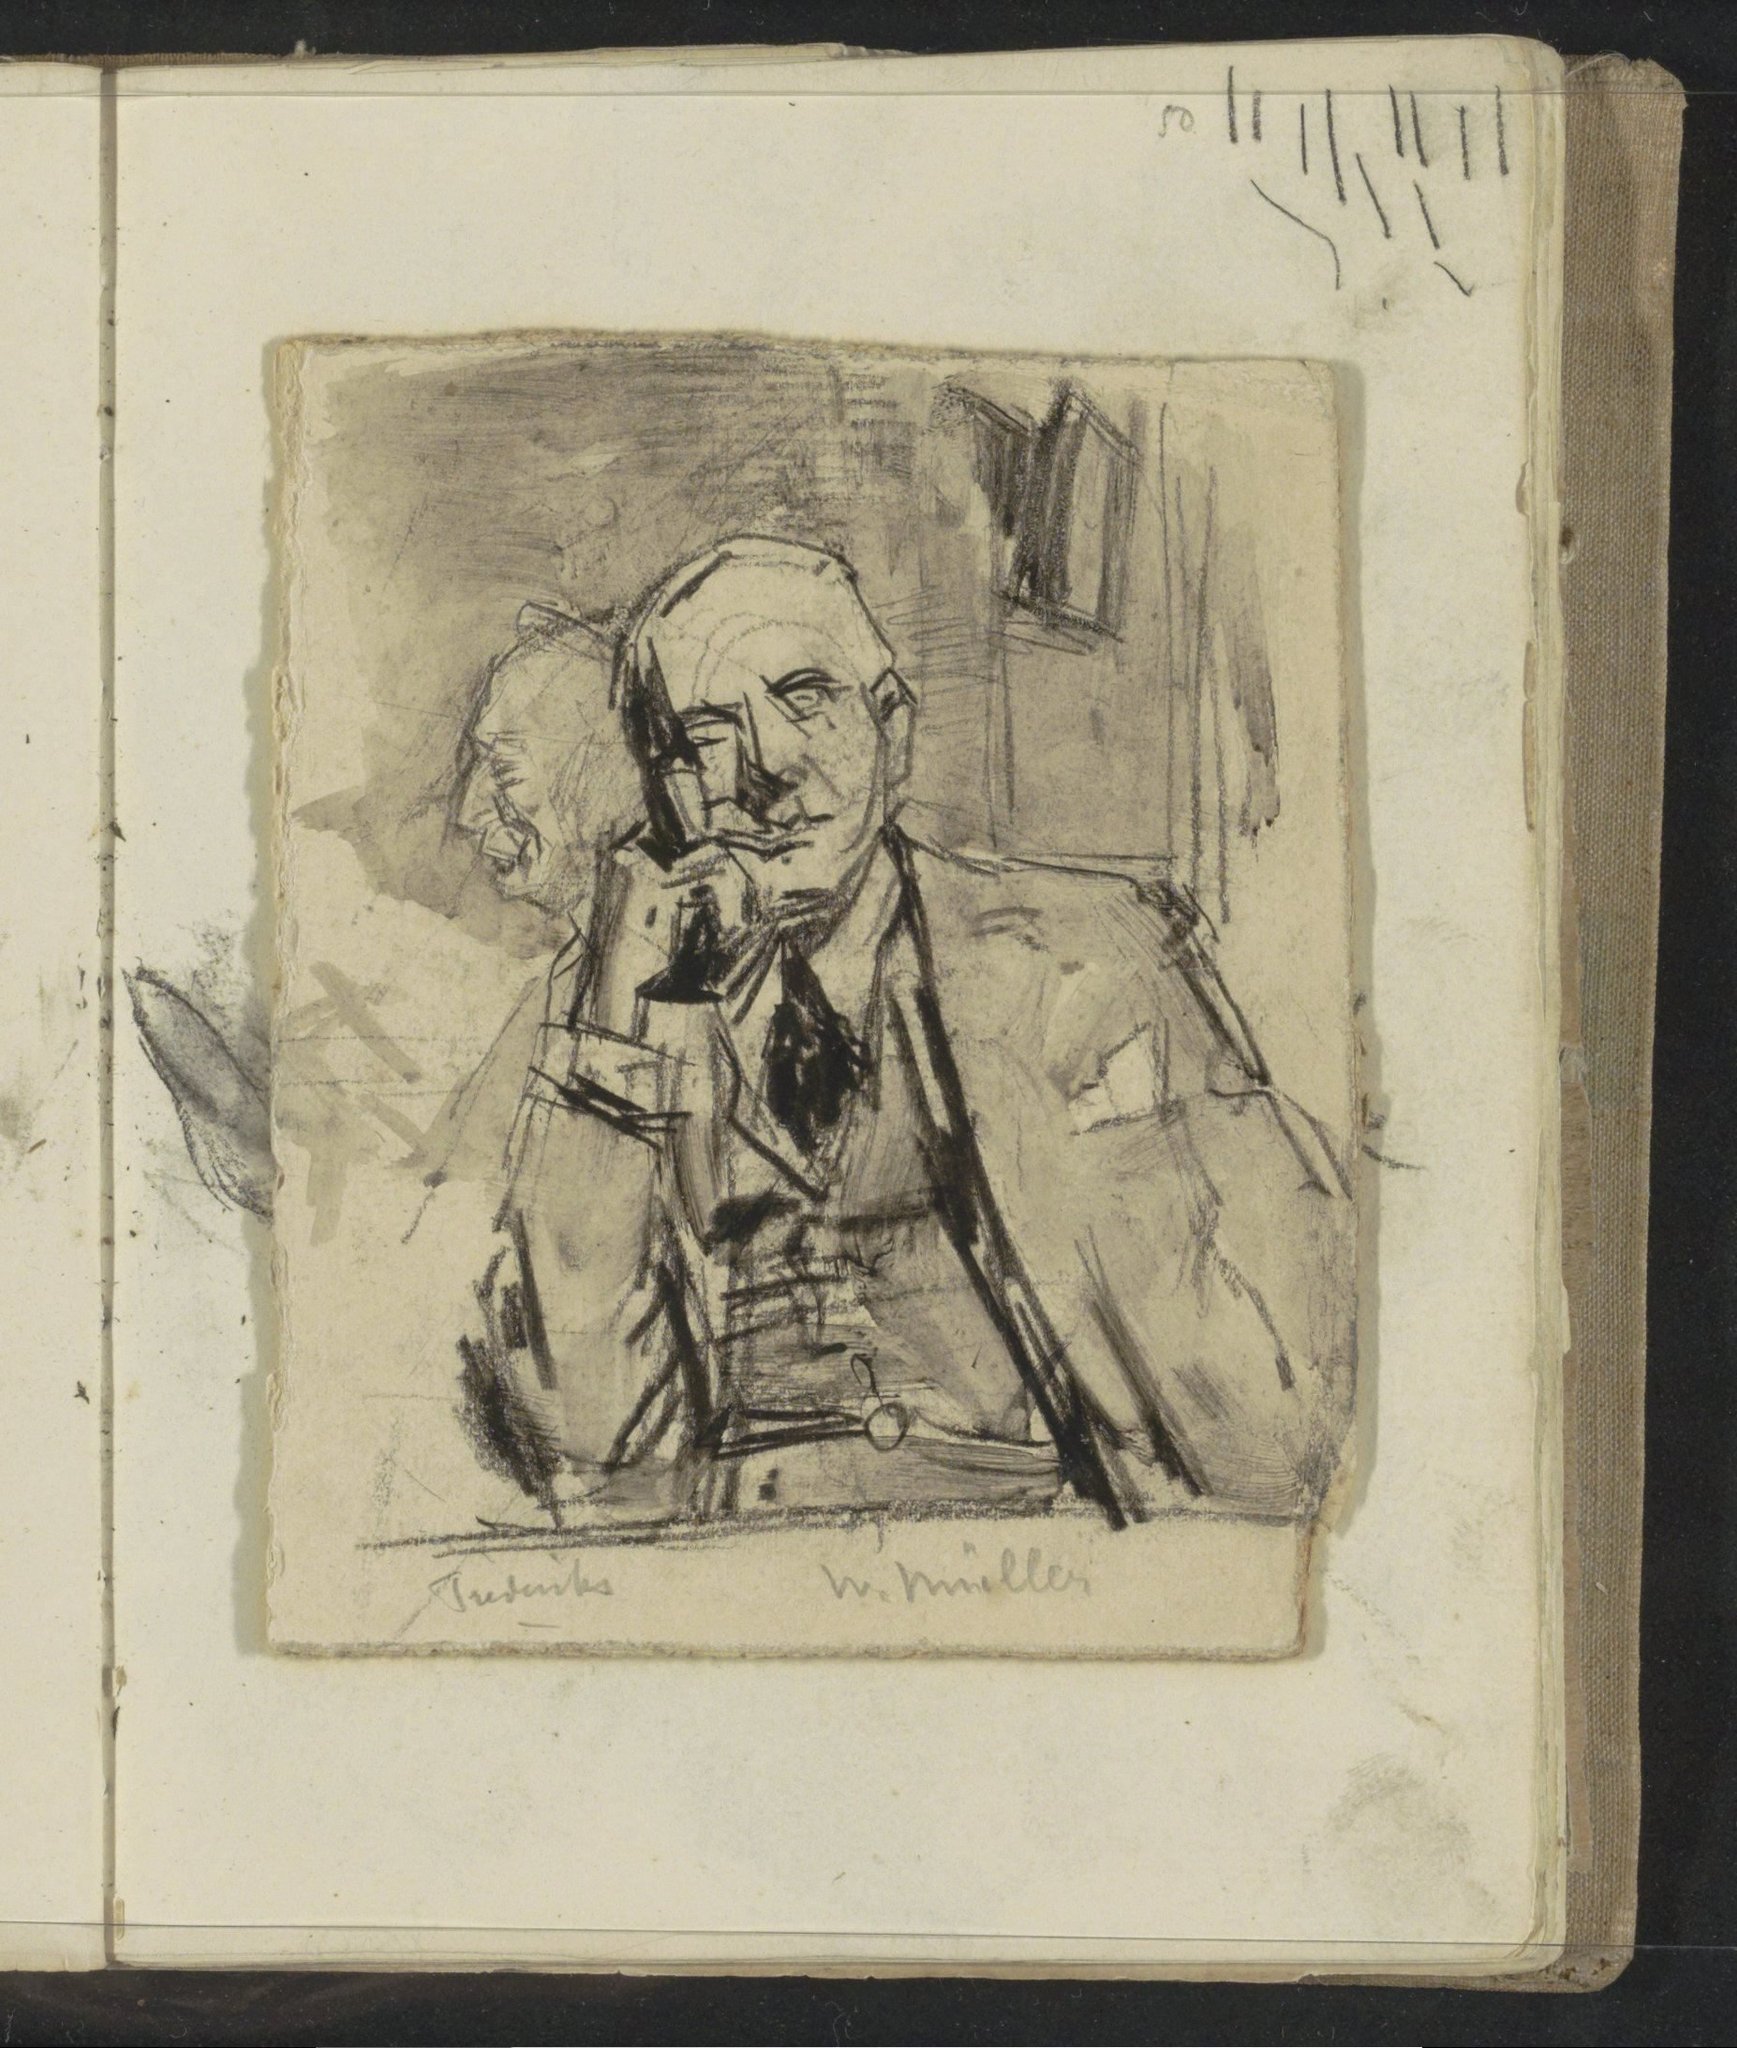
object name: sketchbook leaf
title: Dubbelportret van kunstenaar Willem Müller en een man, genaamd Frederiks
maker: floris arntzenius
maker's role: draughtsman, print maker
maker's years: 1864-1925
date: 1883-1914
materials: cardboard, chalk, paper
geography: the hague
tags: painter, historical persons, portrait, self-portrait of artist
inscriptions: name: ‘Frederiks/ W. Müller’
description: Blad, geplakt op pagina 50 uit een schetsboek met 82 pagina's.